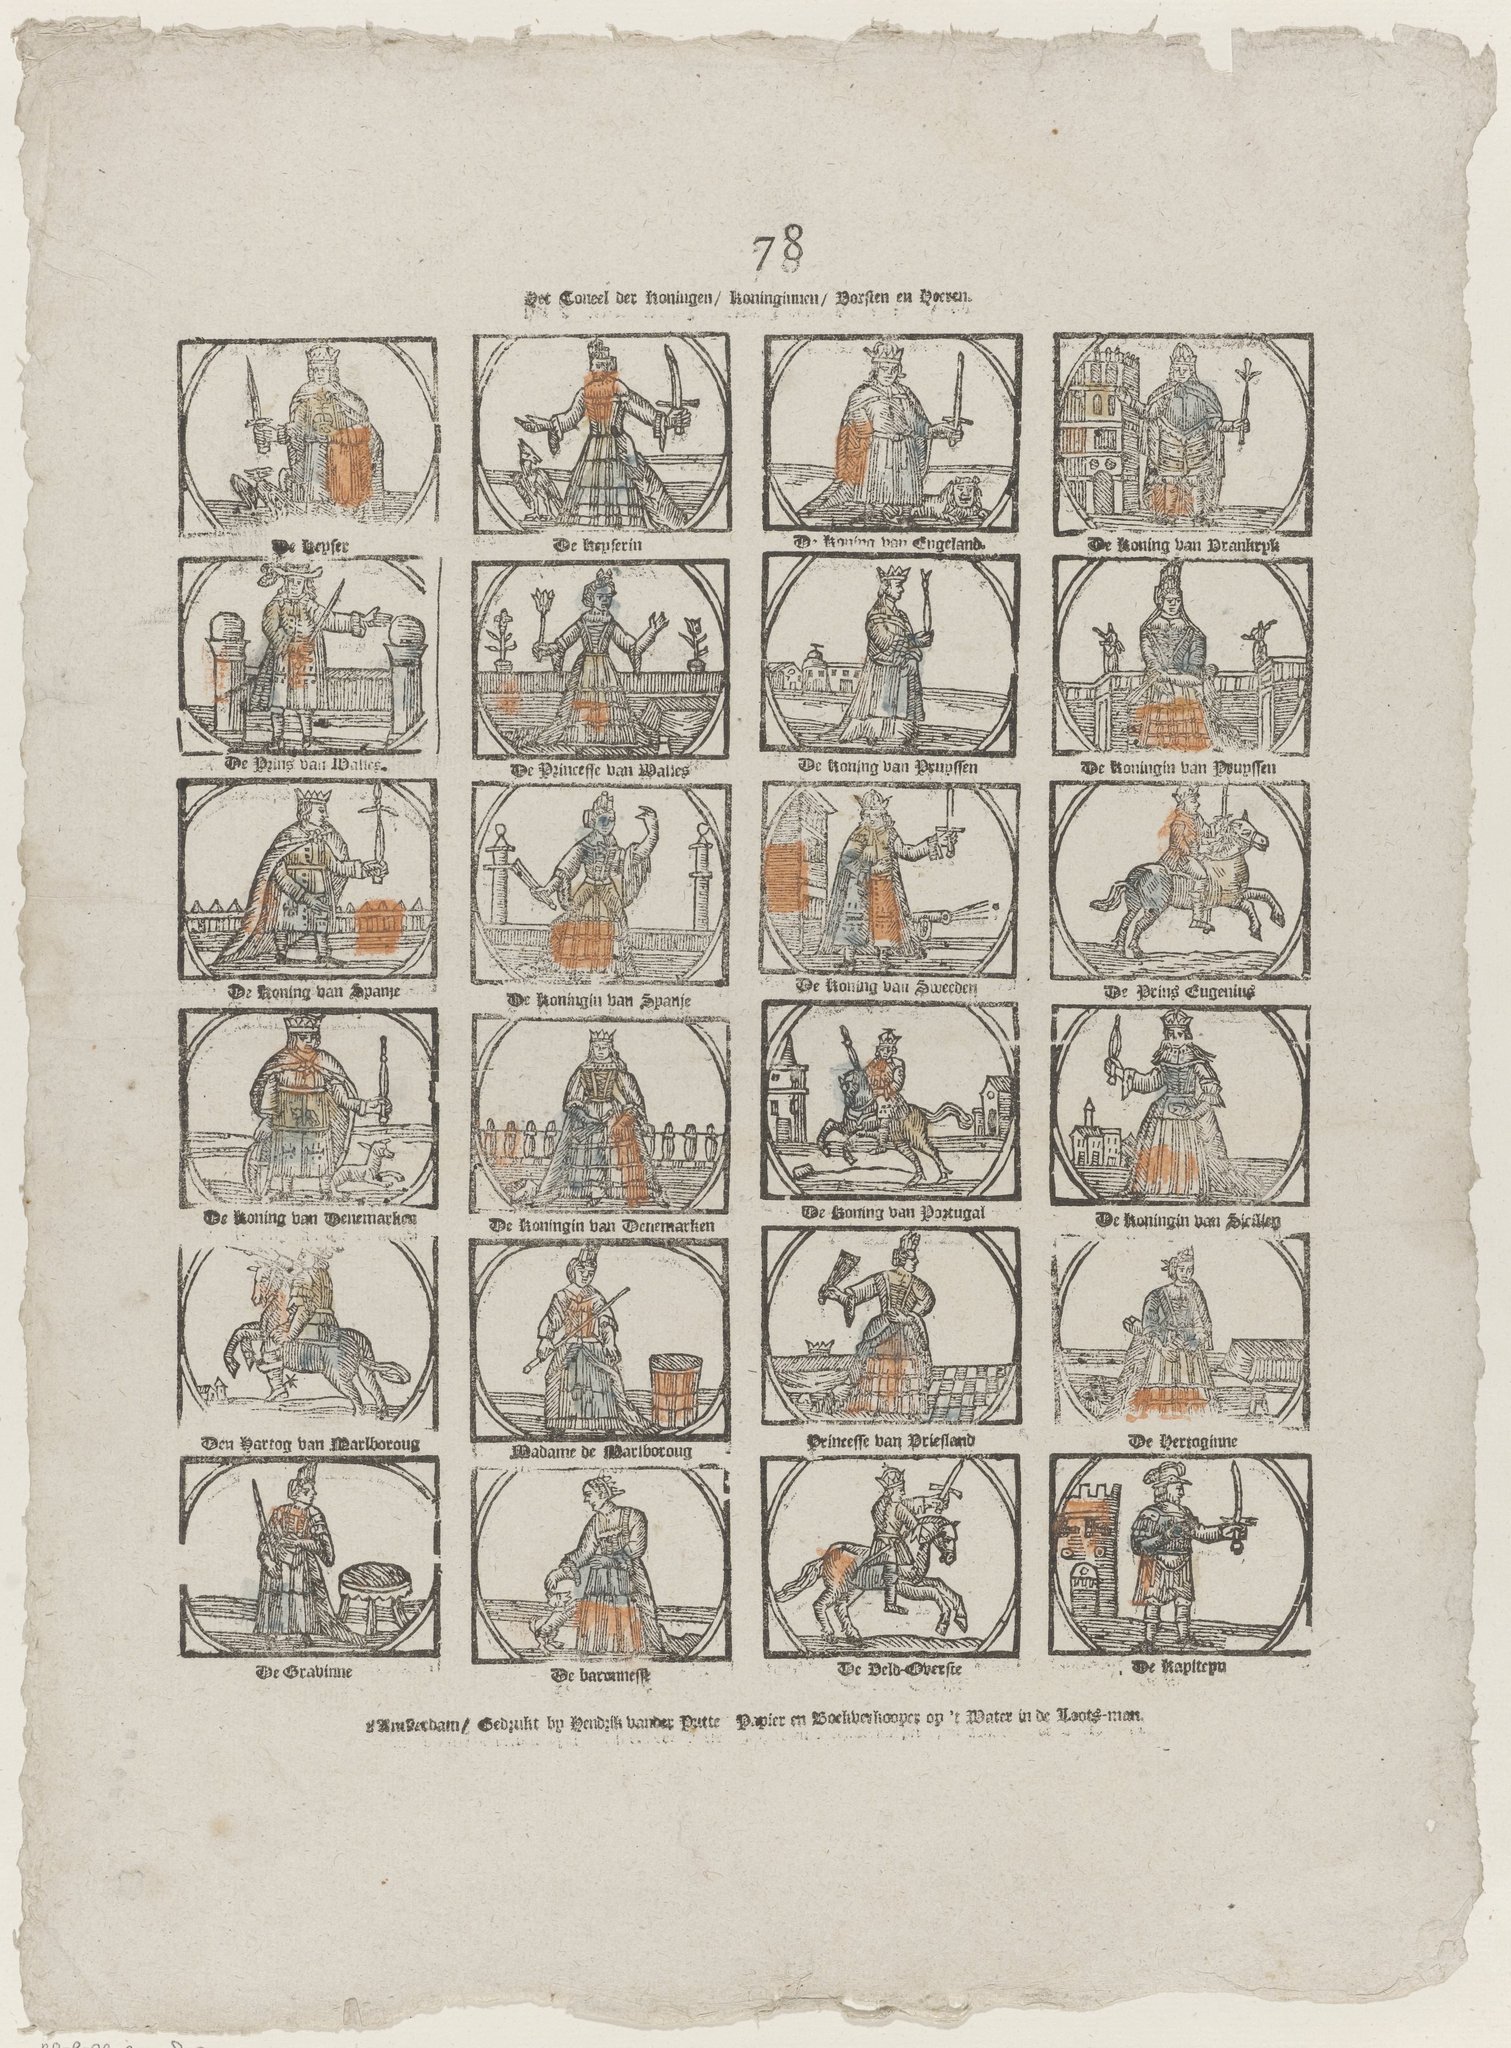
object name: popular print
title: Het toneel der koningen / koninginnen / vorsten en heeren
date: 1761-1765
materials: paper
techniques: colour, letterpress printing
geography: amsterdam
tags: ruler, sovereign - bb - female ruler, ruler, sovereign, nobility and patriciate; chivalry, knighthood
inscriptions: collector's mark: Lugt 2760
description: Blad met 24 voorstellingen van vorsten, vorstinnen en heeren. Onder elke afbeelding een onderschrift. Genummerd midden boven: 78.